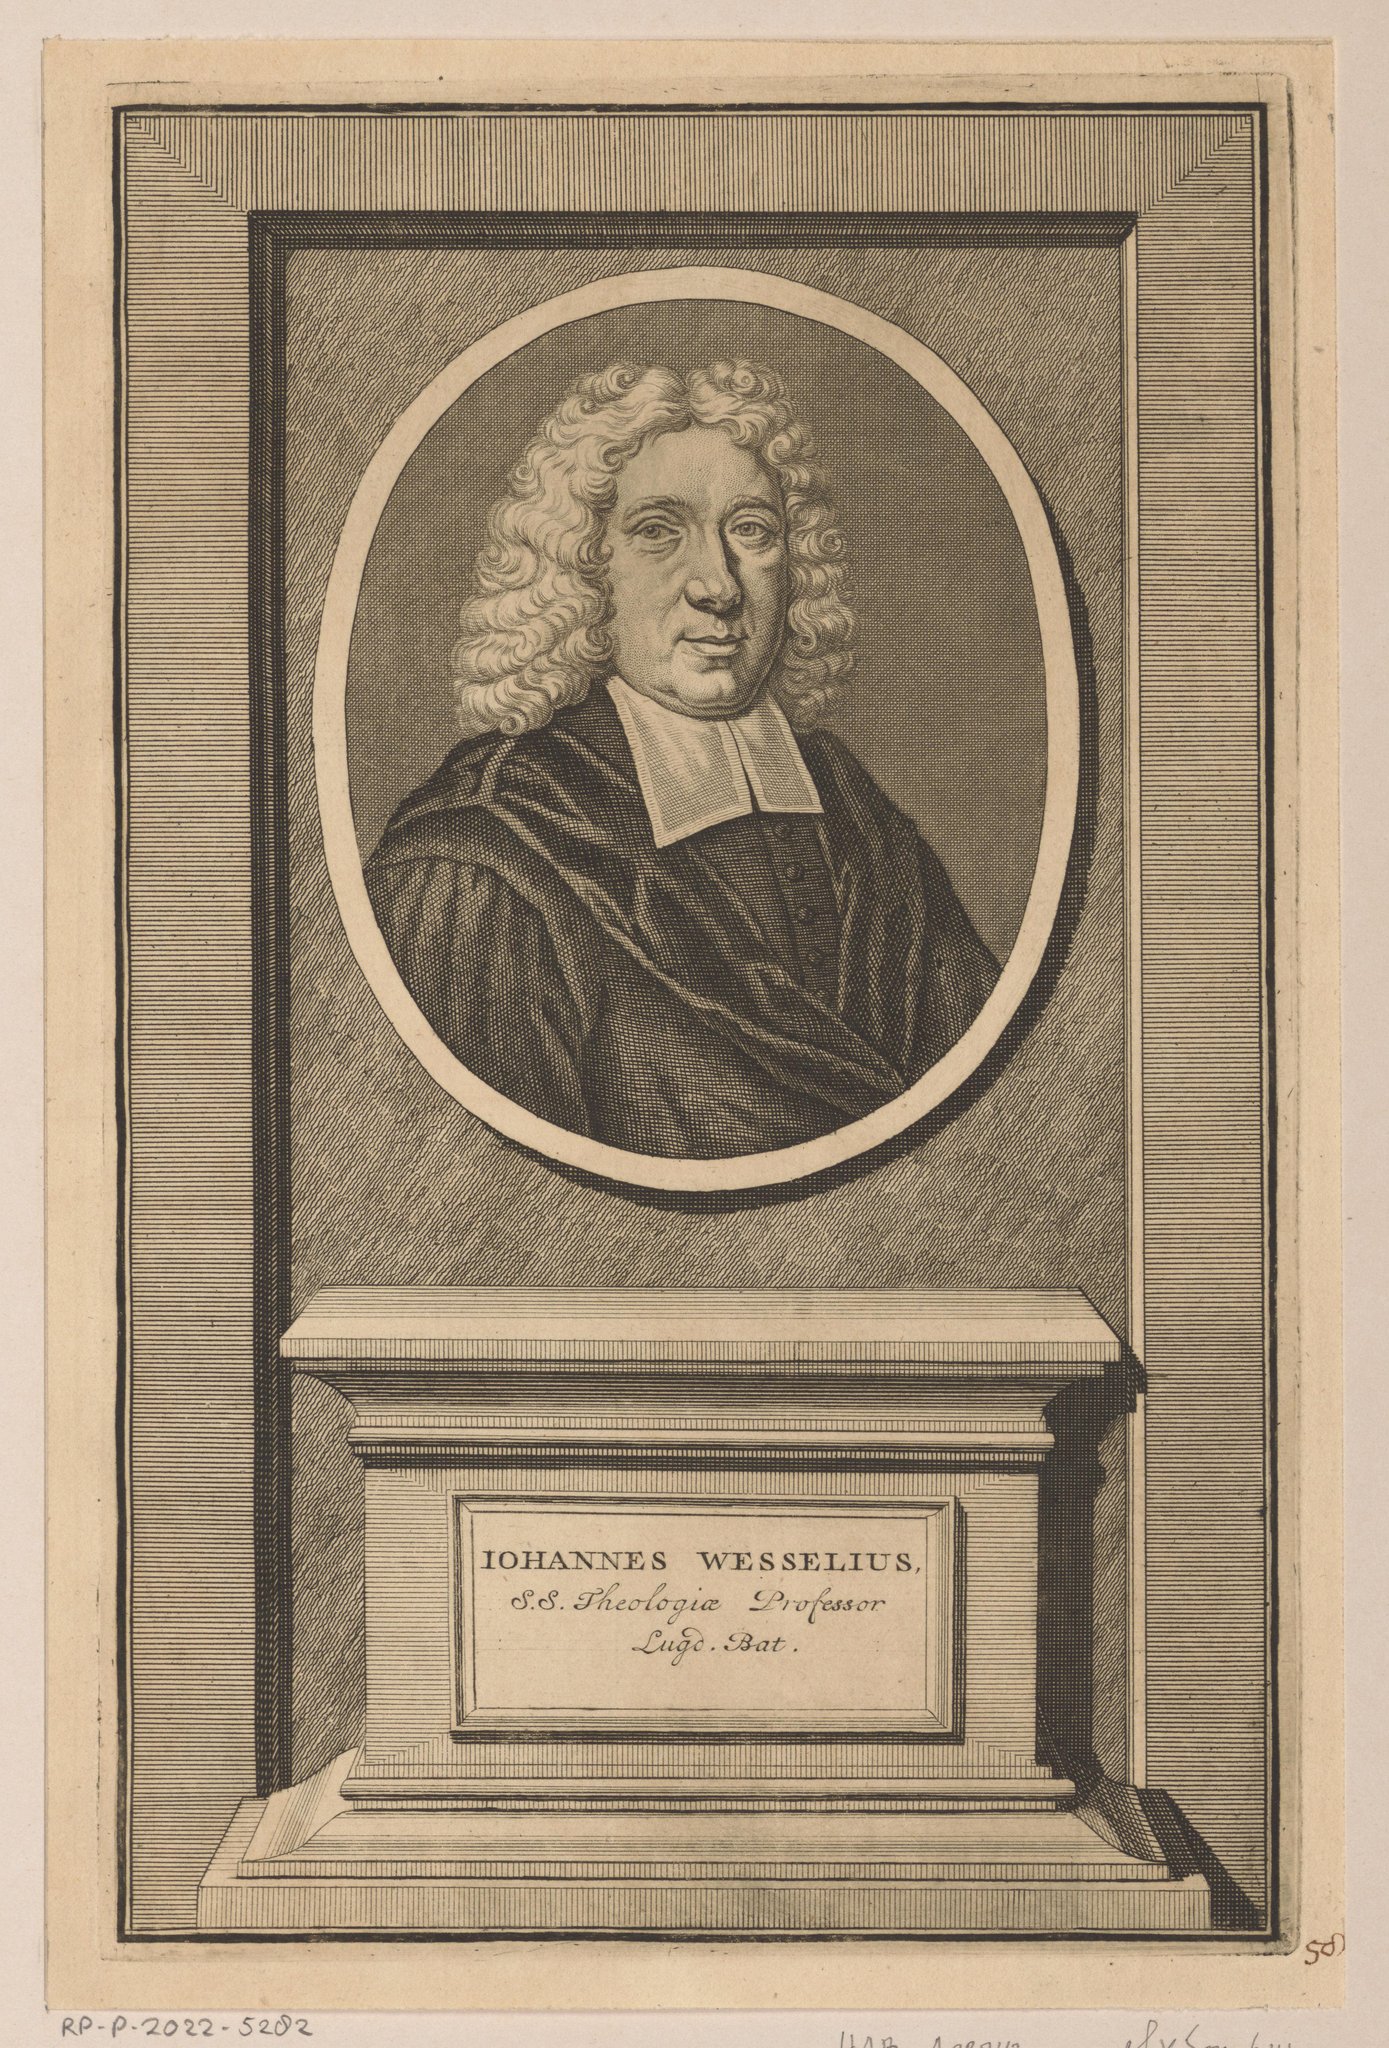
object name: print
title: Portret van Johannes Wesselius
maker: Anonymous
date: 1720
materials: paper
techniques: engraving, etching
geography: northern netherlands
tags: leiden, theologian, historical persons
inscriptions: number: ‘58’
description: Prent waarschijnlijk uit: Fundatoris, curatorum et professorum celeberrimorum, aliorumque illustrium virorum (...). Leiden: Pieter van der Aa, 1720.